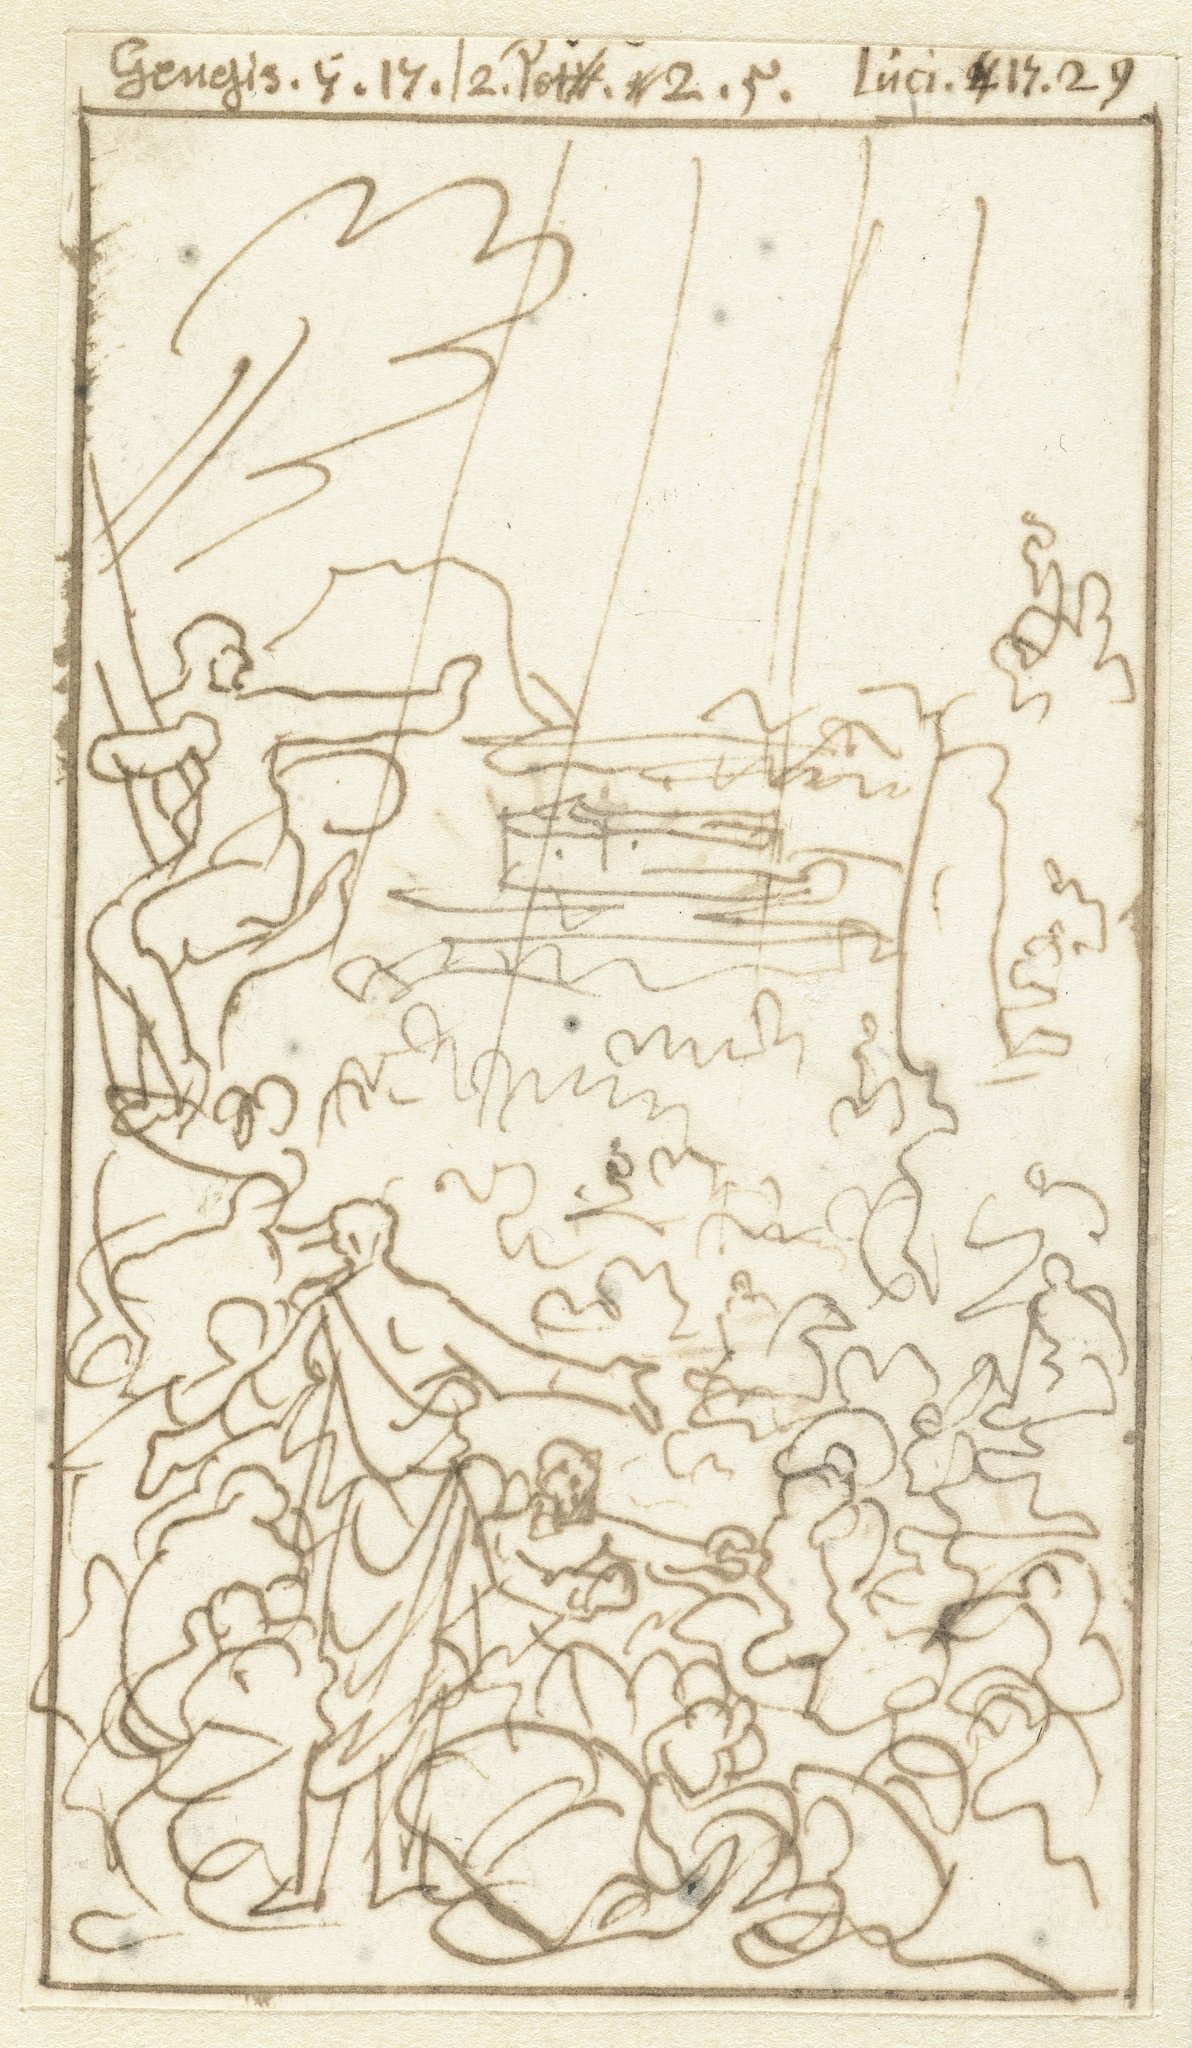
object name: design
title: De zondvloed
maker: jan luyken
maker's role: draughtsman, print maker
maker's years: 1649-1712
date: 1710-1712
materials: ink, paper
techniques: pen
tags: the ark is floating on the waters, while life on earth is destroyed ~ story of noah